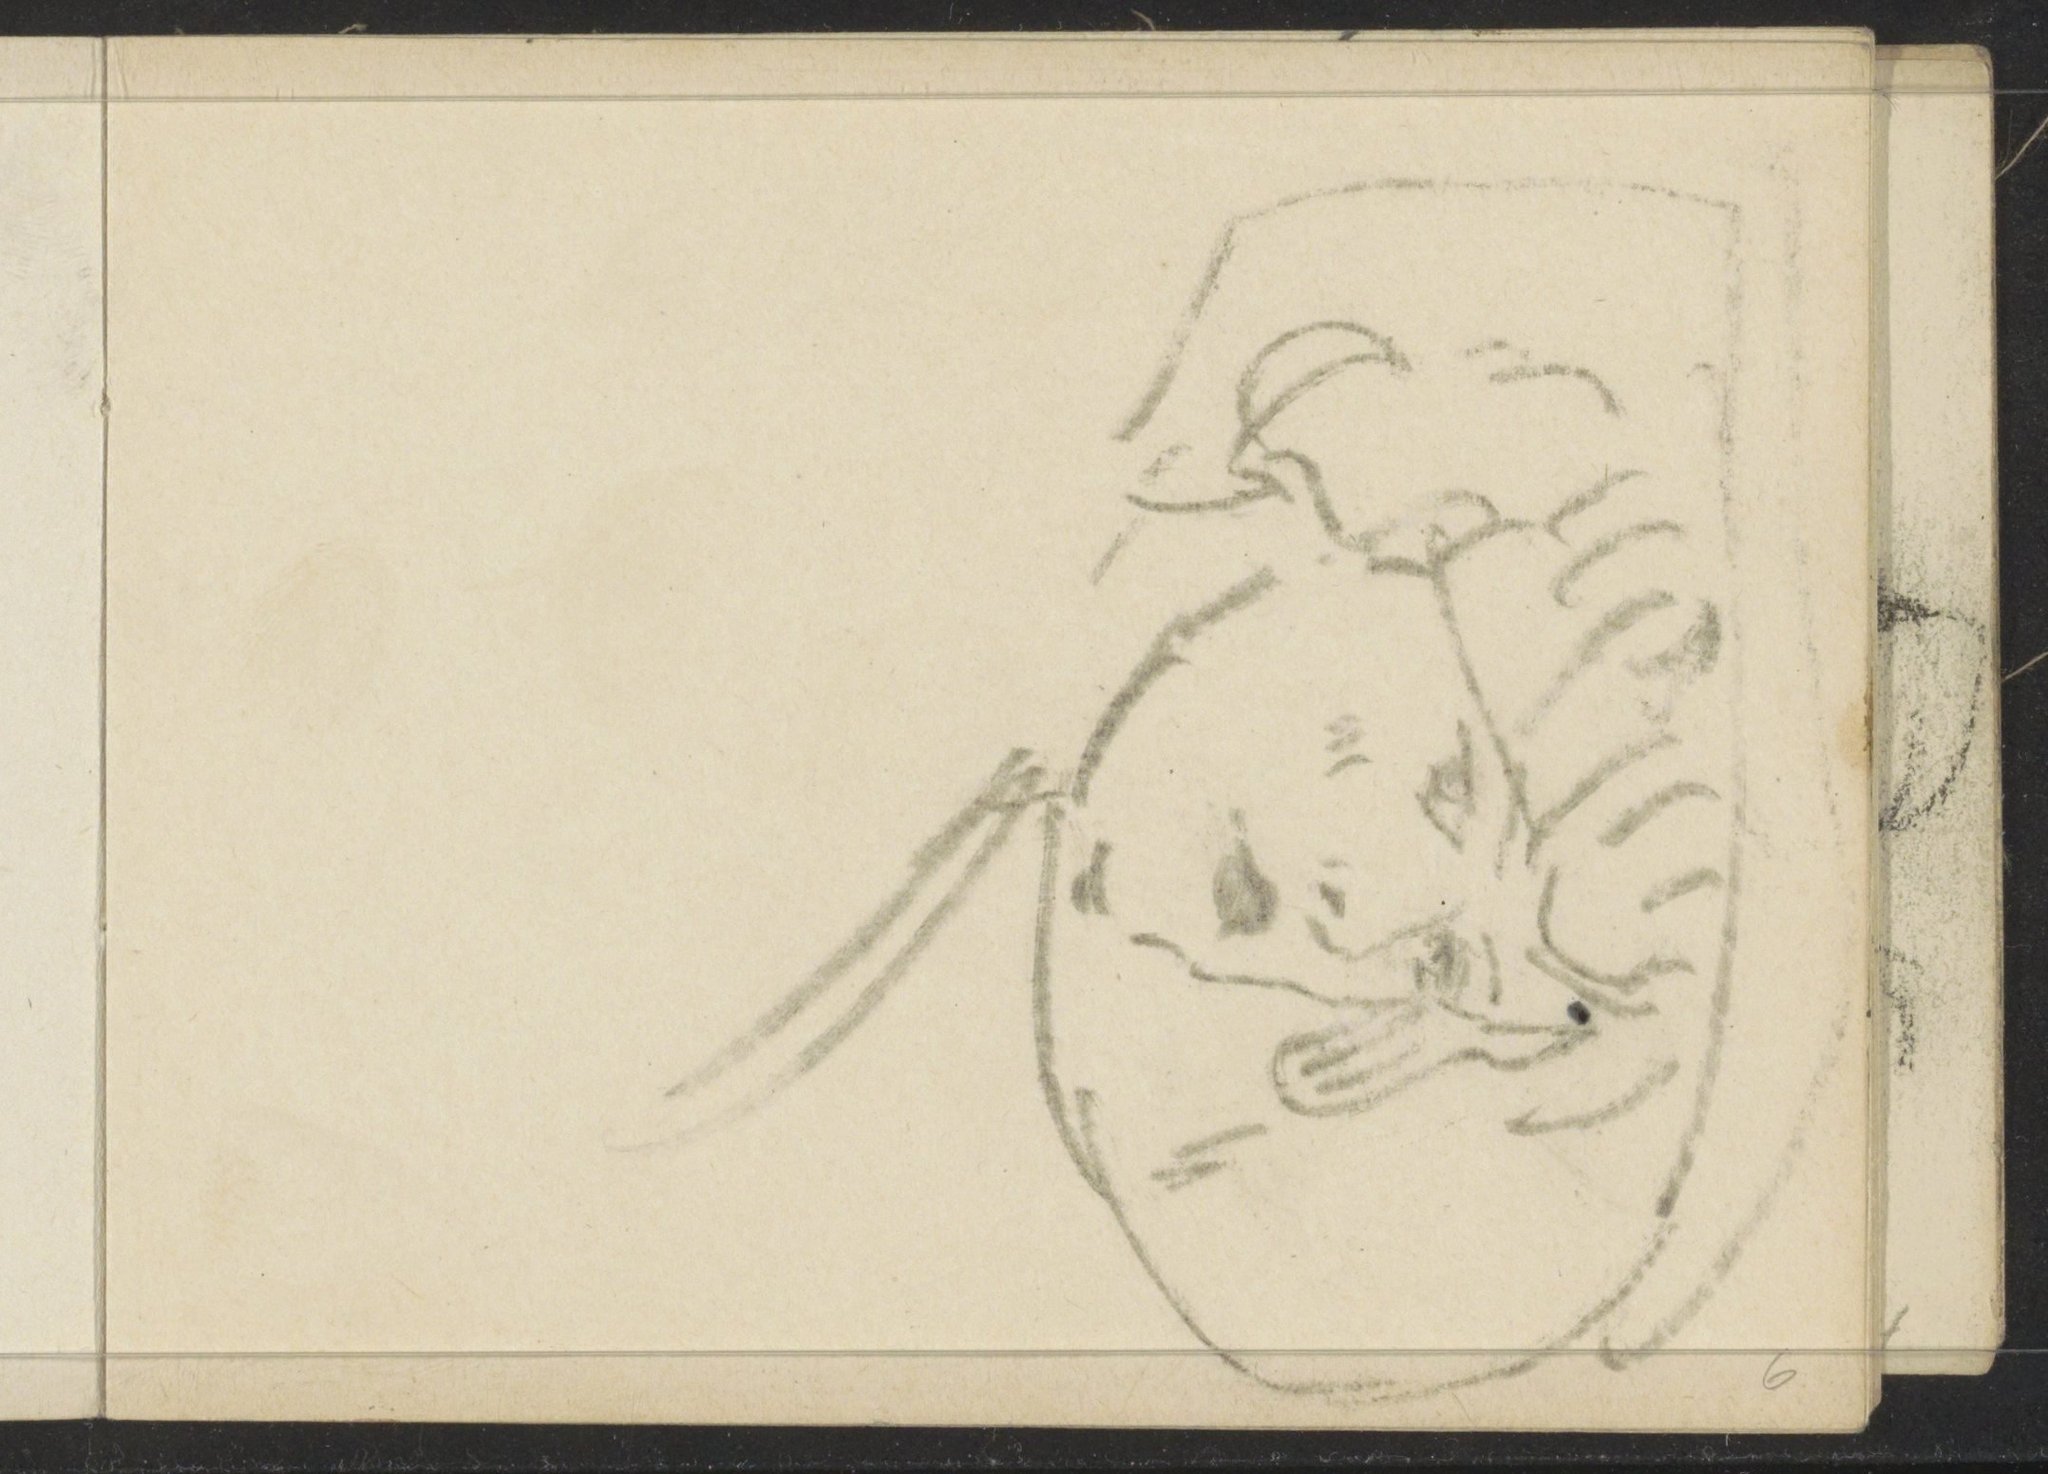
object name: sketchbook leaf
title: Abklatsch van de krijttekening op blad 5 verso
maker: isaac israels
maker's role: draughtsman, painter, print maker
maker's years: 1865-1934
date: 1923-1934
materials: paper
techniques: printmaking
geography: the hague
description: Blad 6 recto uit schetsboek LVIII met 14 bladen.